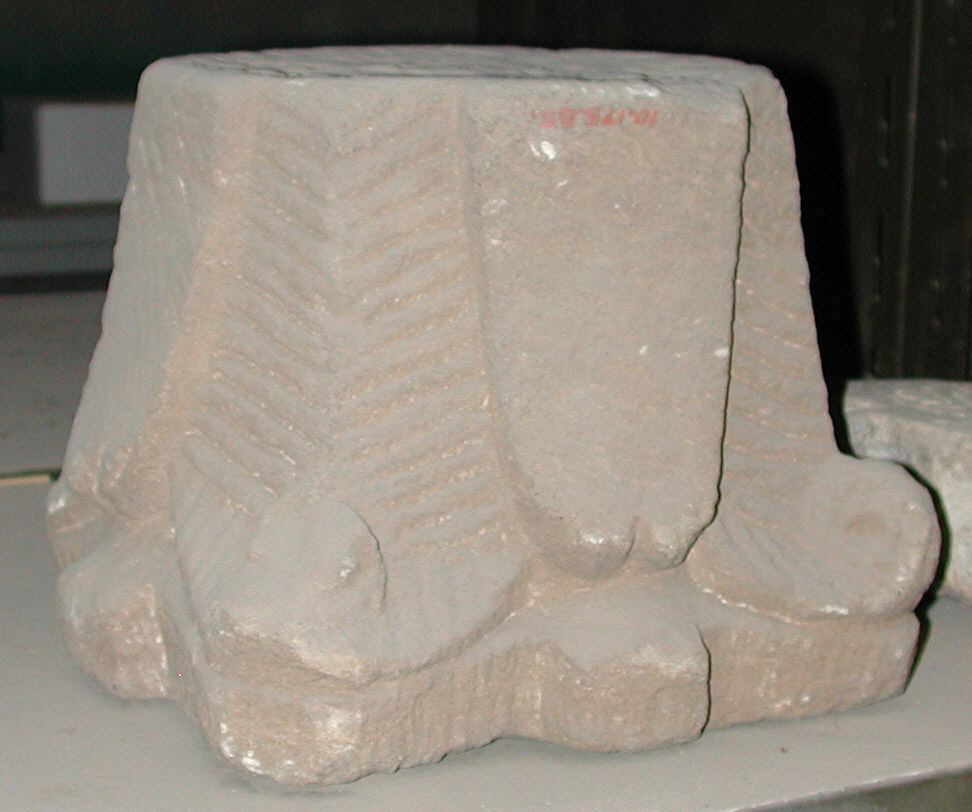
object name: capital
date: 501-700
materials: stone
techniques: carving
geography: egypt